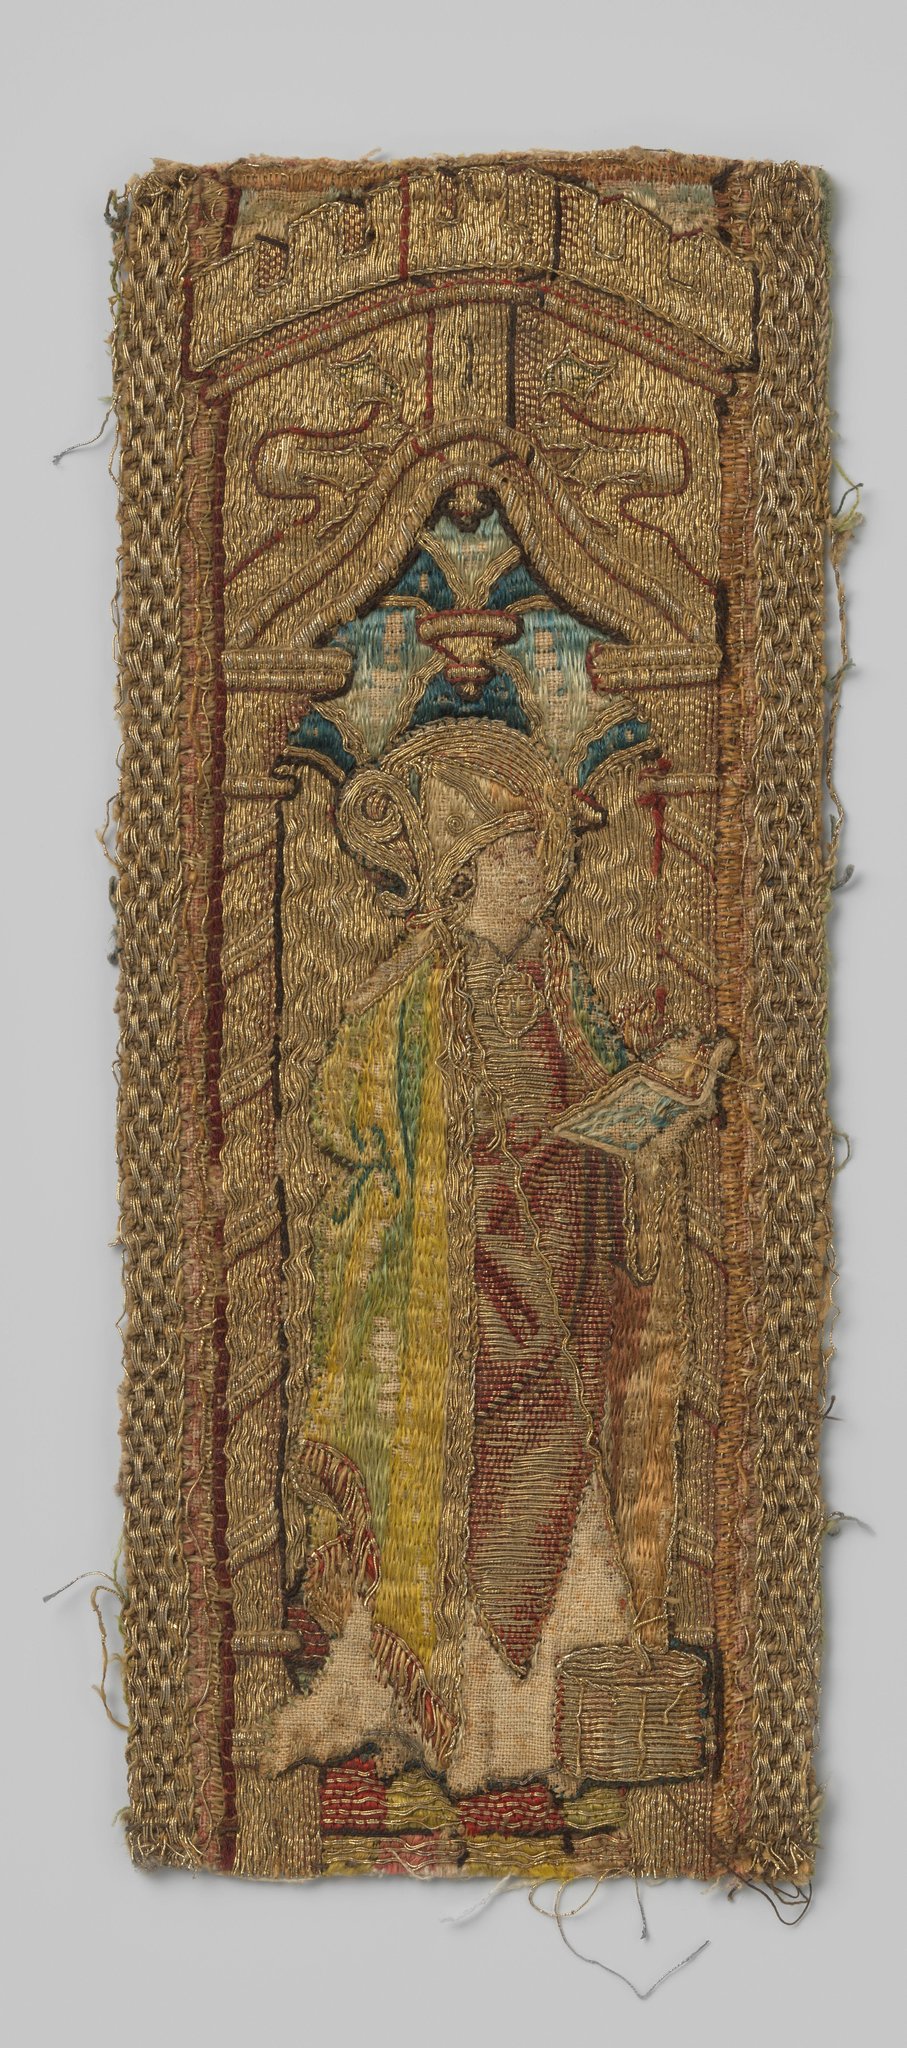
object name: aurifries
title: Fragment van een aurifries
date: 1500-1550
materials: gold thread, textile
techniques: embroidered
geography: netherlands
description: Fragment van een aurifries, met borduurwerk. Het fragment heeft een afbeelding van een arcade met een gouden fond en de heilige Willebrordus (bisschop, kromstaf en waterbekken).